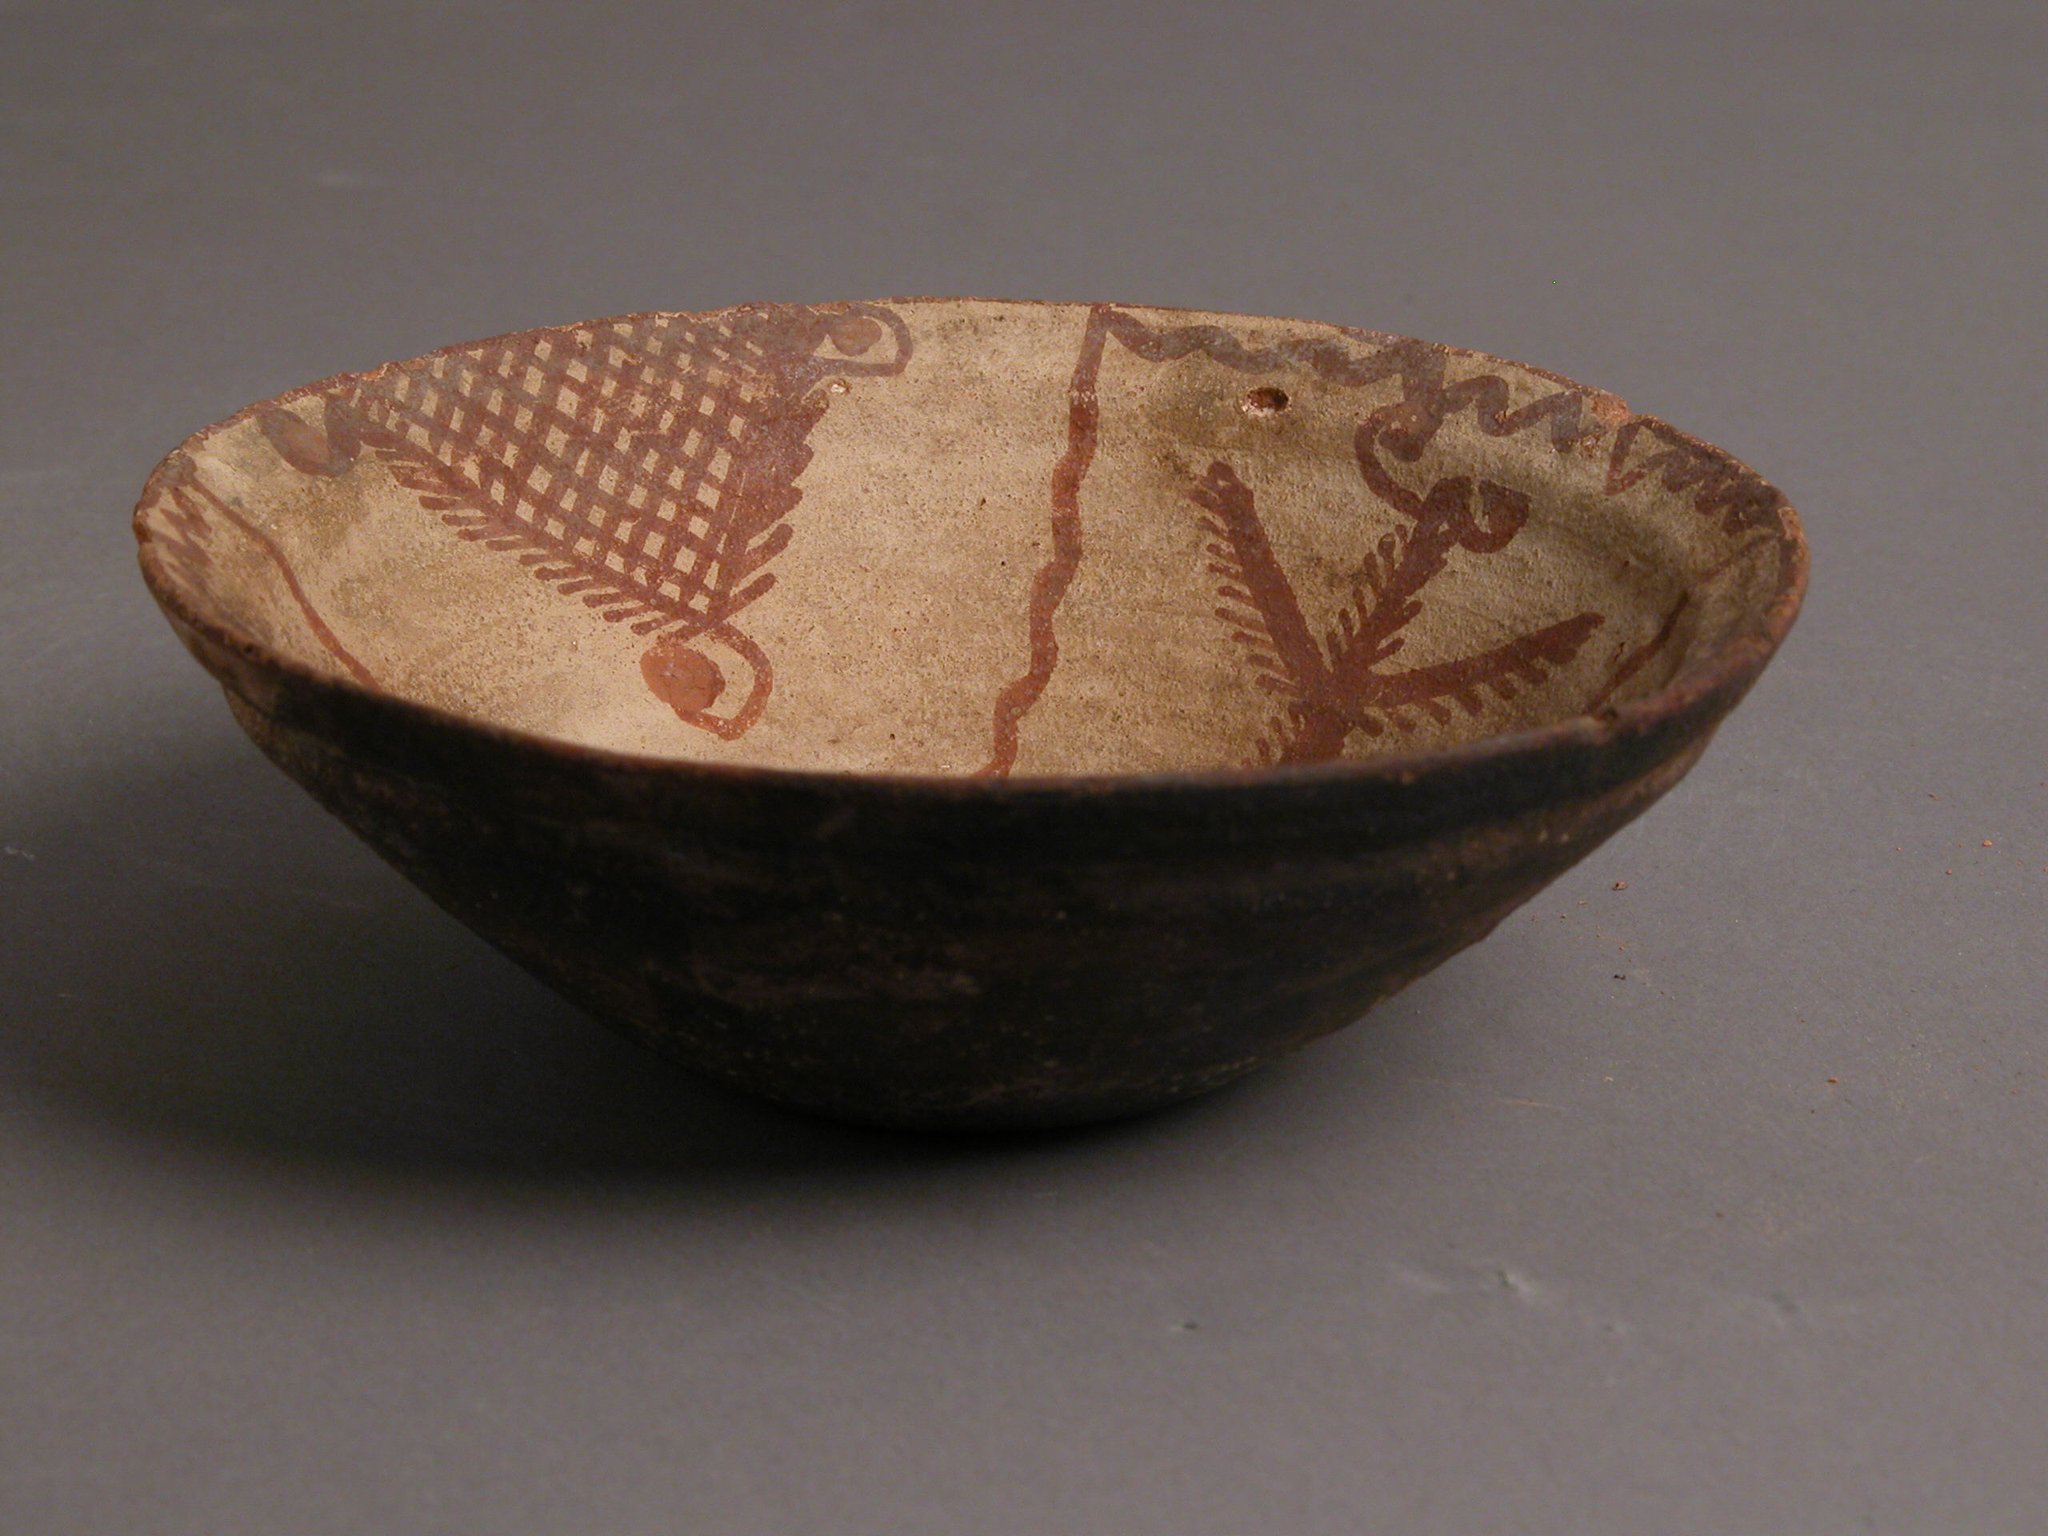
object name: bowl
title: Bowl with Floral Motifs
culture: coptic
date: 301-700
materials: earthenware, pigment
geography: egypt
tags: bowls